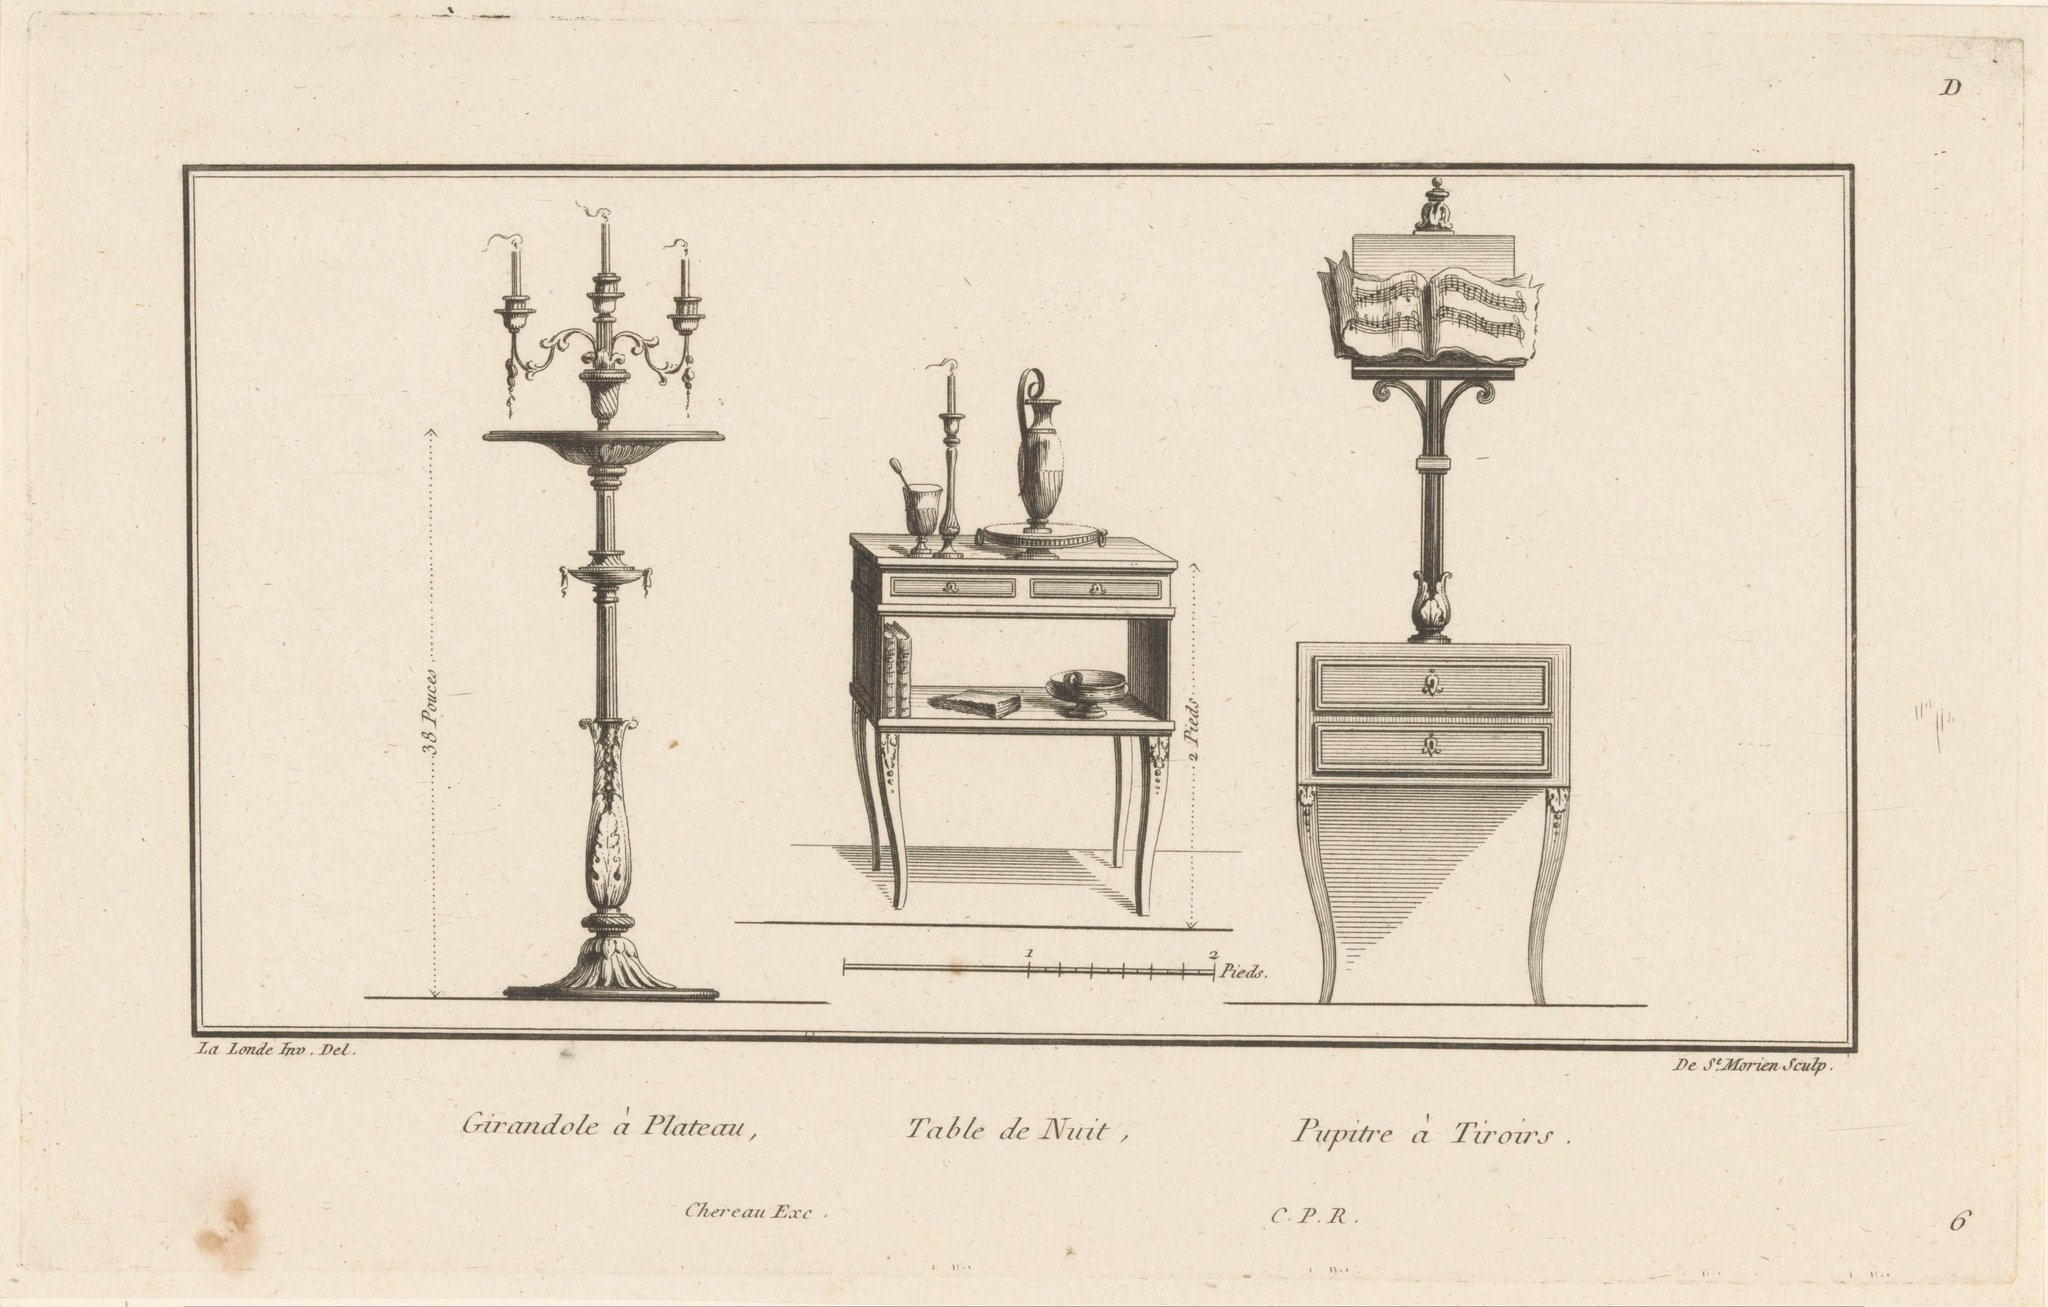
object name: ornament print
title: D Quatrieme Cahier de Meubles et d'Ébénisteries, Dessin's par La Londe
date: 1784-1785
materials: paper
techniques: etching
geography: paris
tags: chandelier, candelabrum, table, accessories ~ music: metronome, music-stand, tuning-fork, etc.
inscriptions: collector's mark: Lugt 2760, collector's mark: Lugt 2228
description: Links een driearmige girandole op een hoog standaard. In het midden een nachtkast met twee lades en een plank, met een kan, kandelaar, boeken en een schaal. Rechts een muziekstandaard op een ladekast met twee lades.